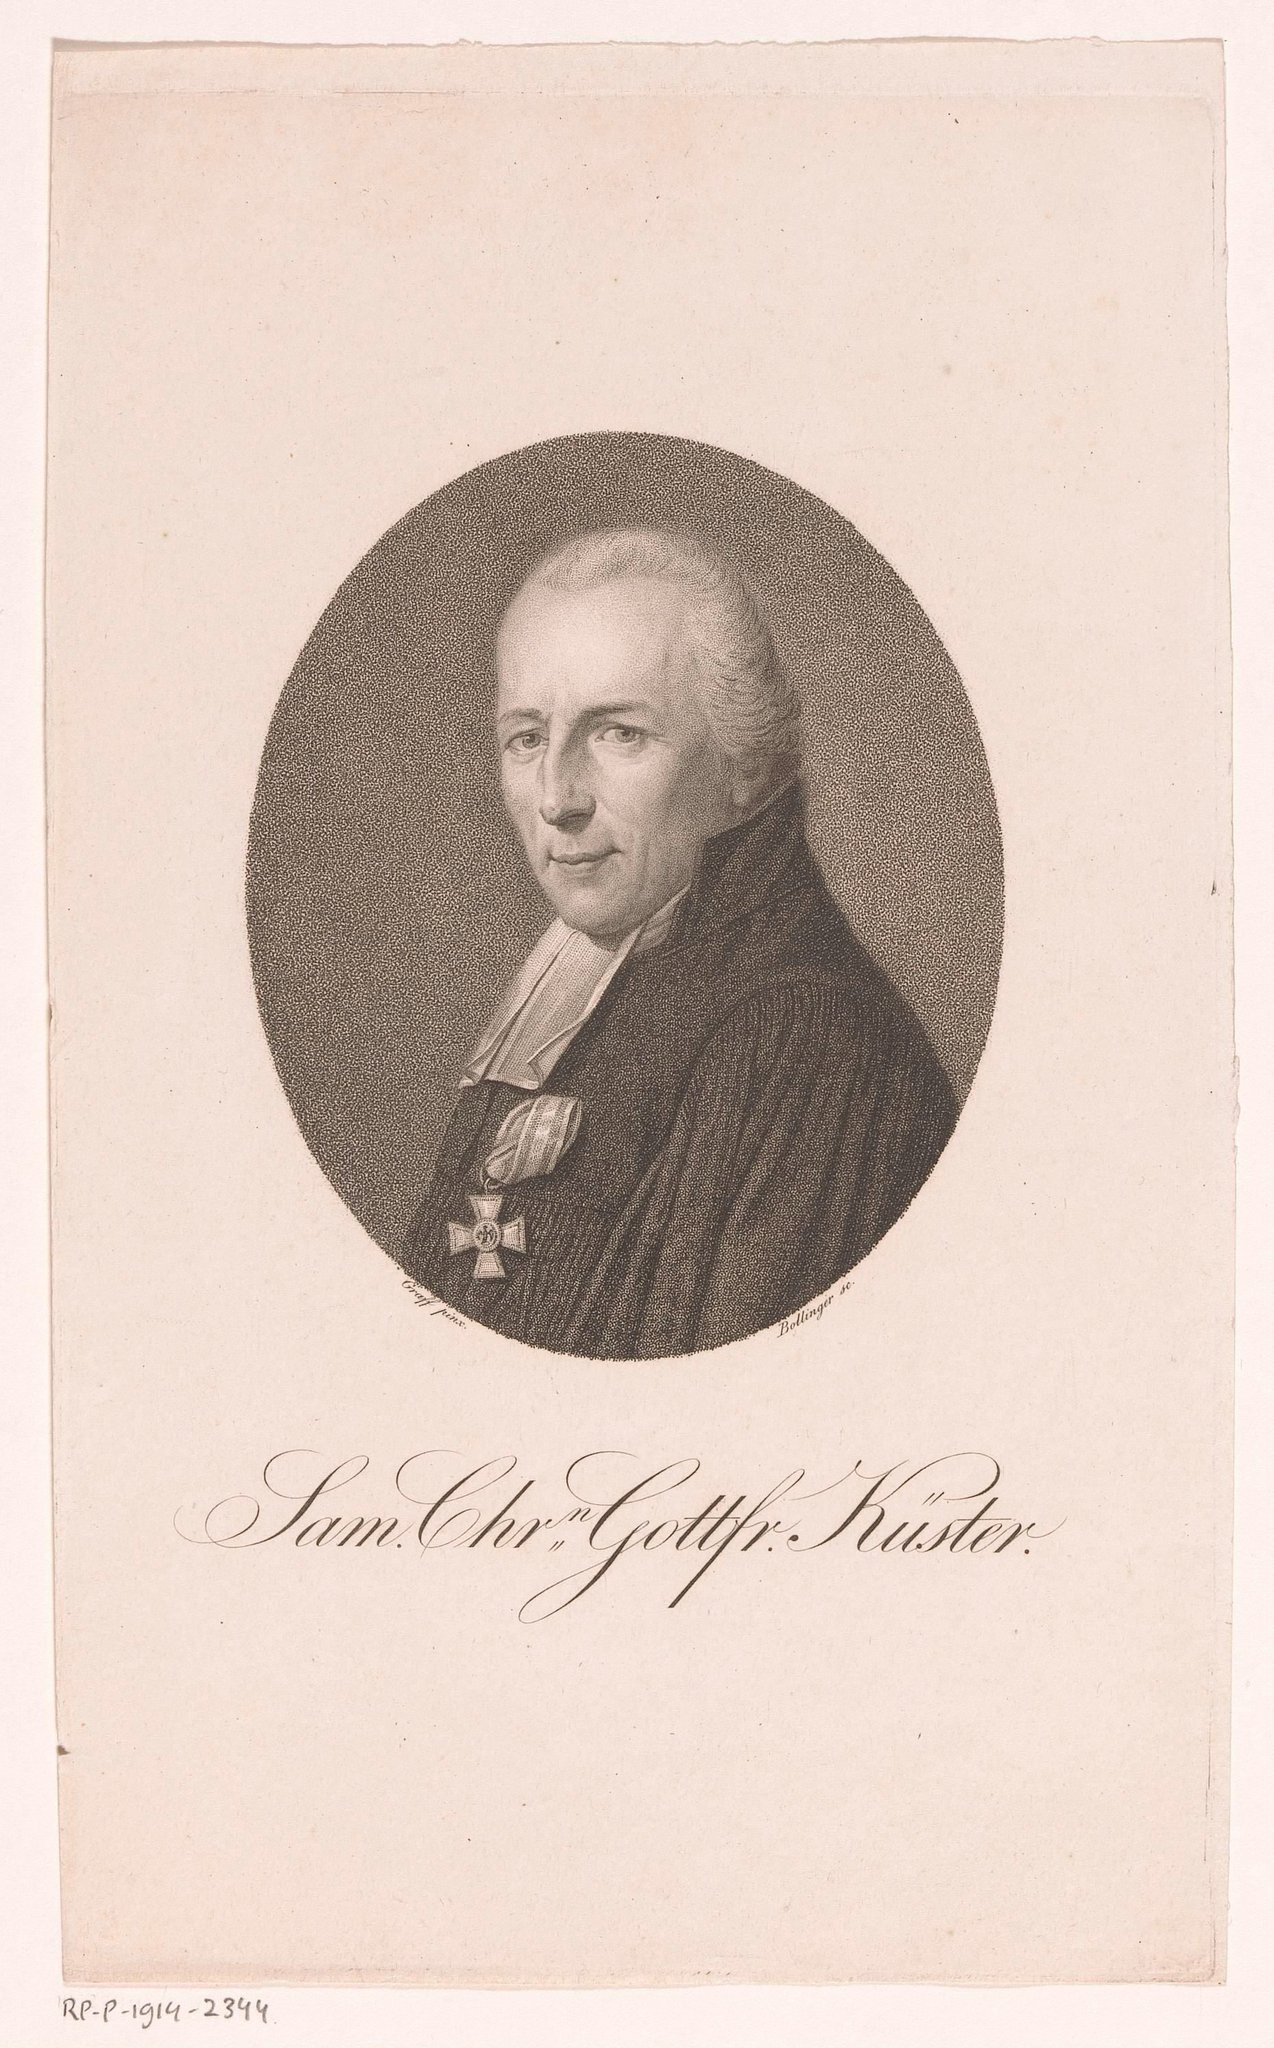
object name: print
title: Portret van Samuel Christian Gottfried Küster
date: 1787-1825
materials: paper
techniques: stippling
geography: berlin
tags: berlin, knighthood order, historical persons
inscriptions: collector's mark: Lugt 2228